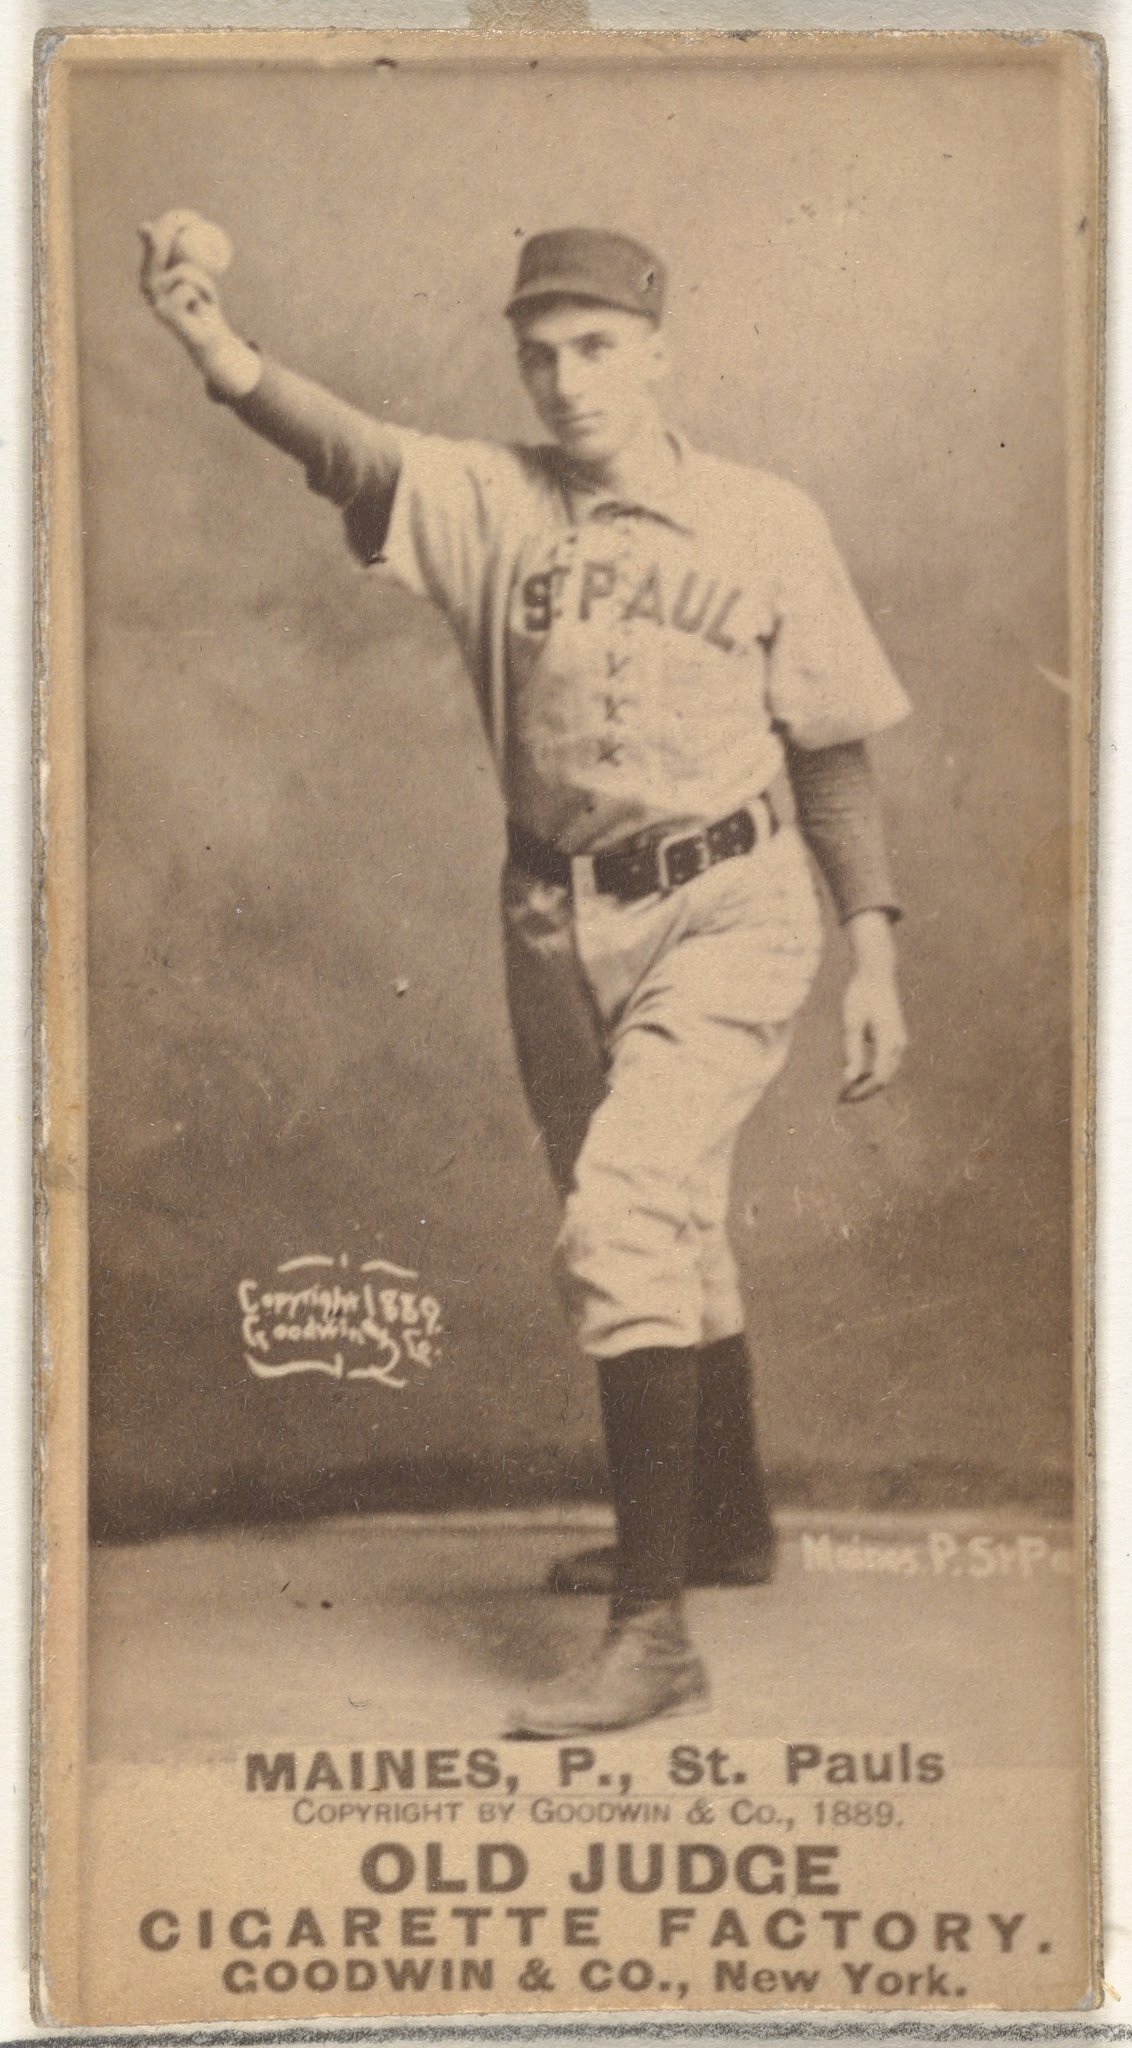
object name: baseball card, photograph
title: Willard Eben Mains, Pitcher, St. Paul Apostles, from the Old Judge series (N172) for Old Judge Cigarettes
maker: goodwin & company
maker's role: publisher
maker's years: 1850-1950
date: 1889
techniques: albumen silver print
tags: men,portraits,baseball,athletes